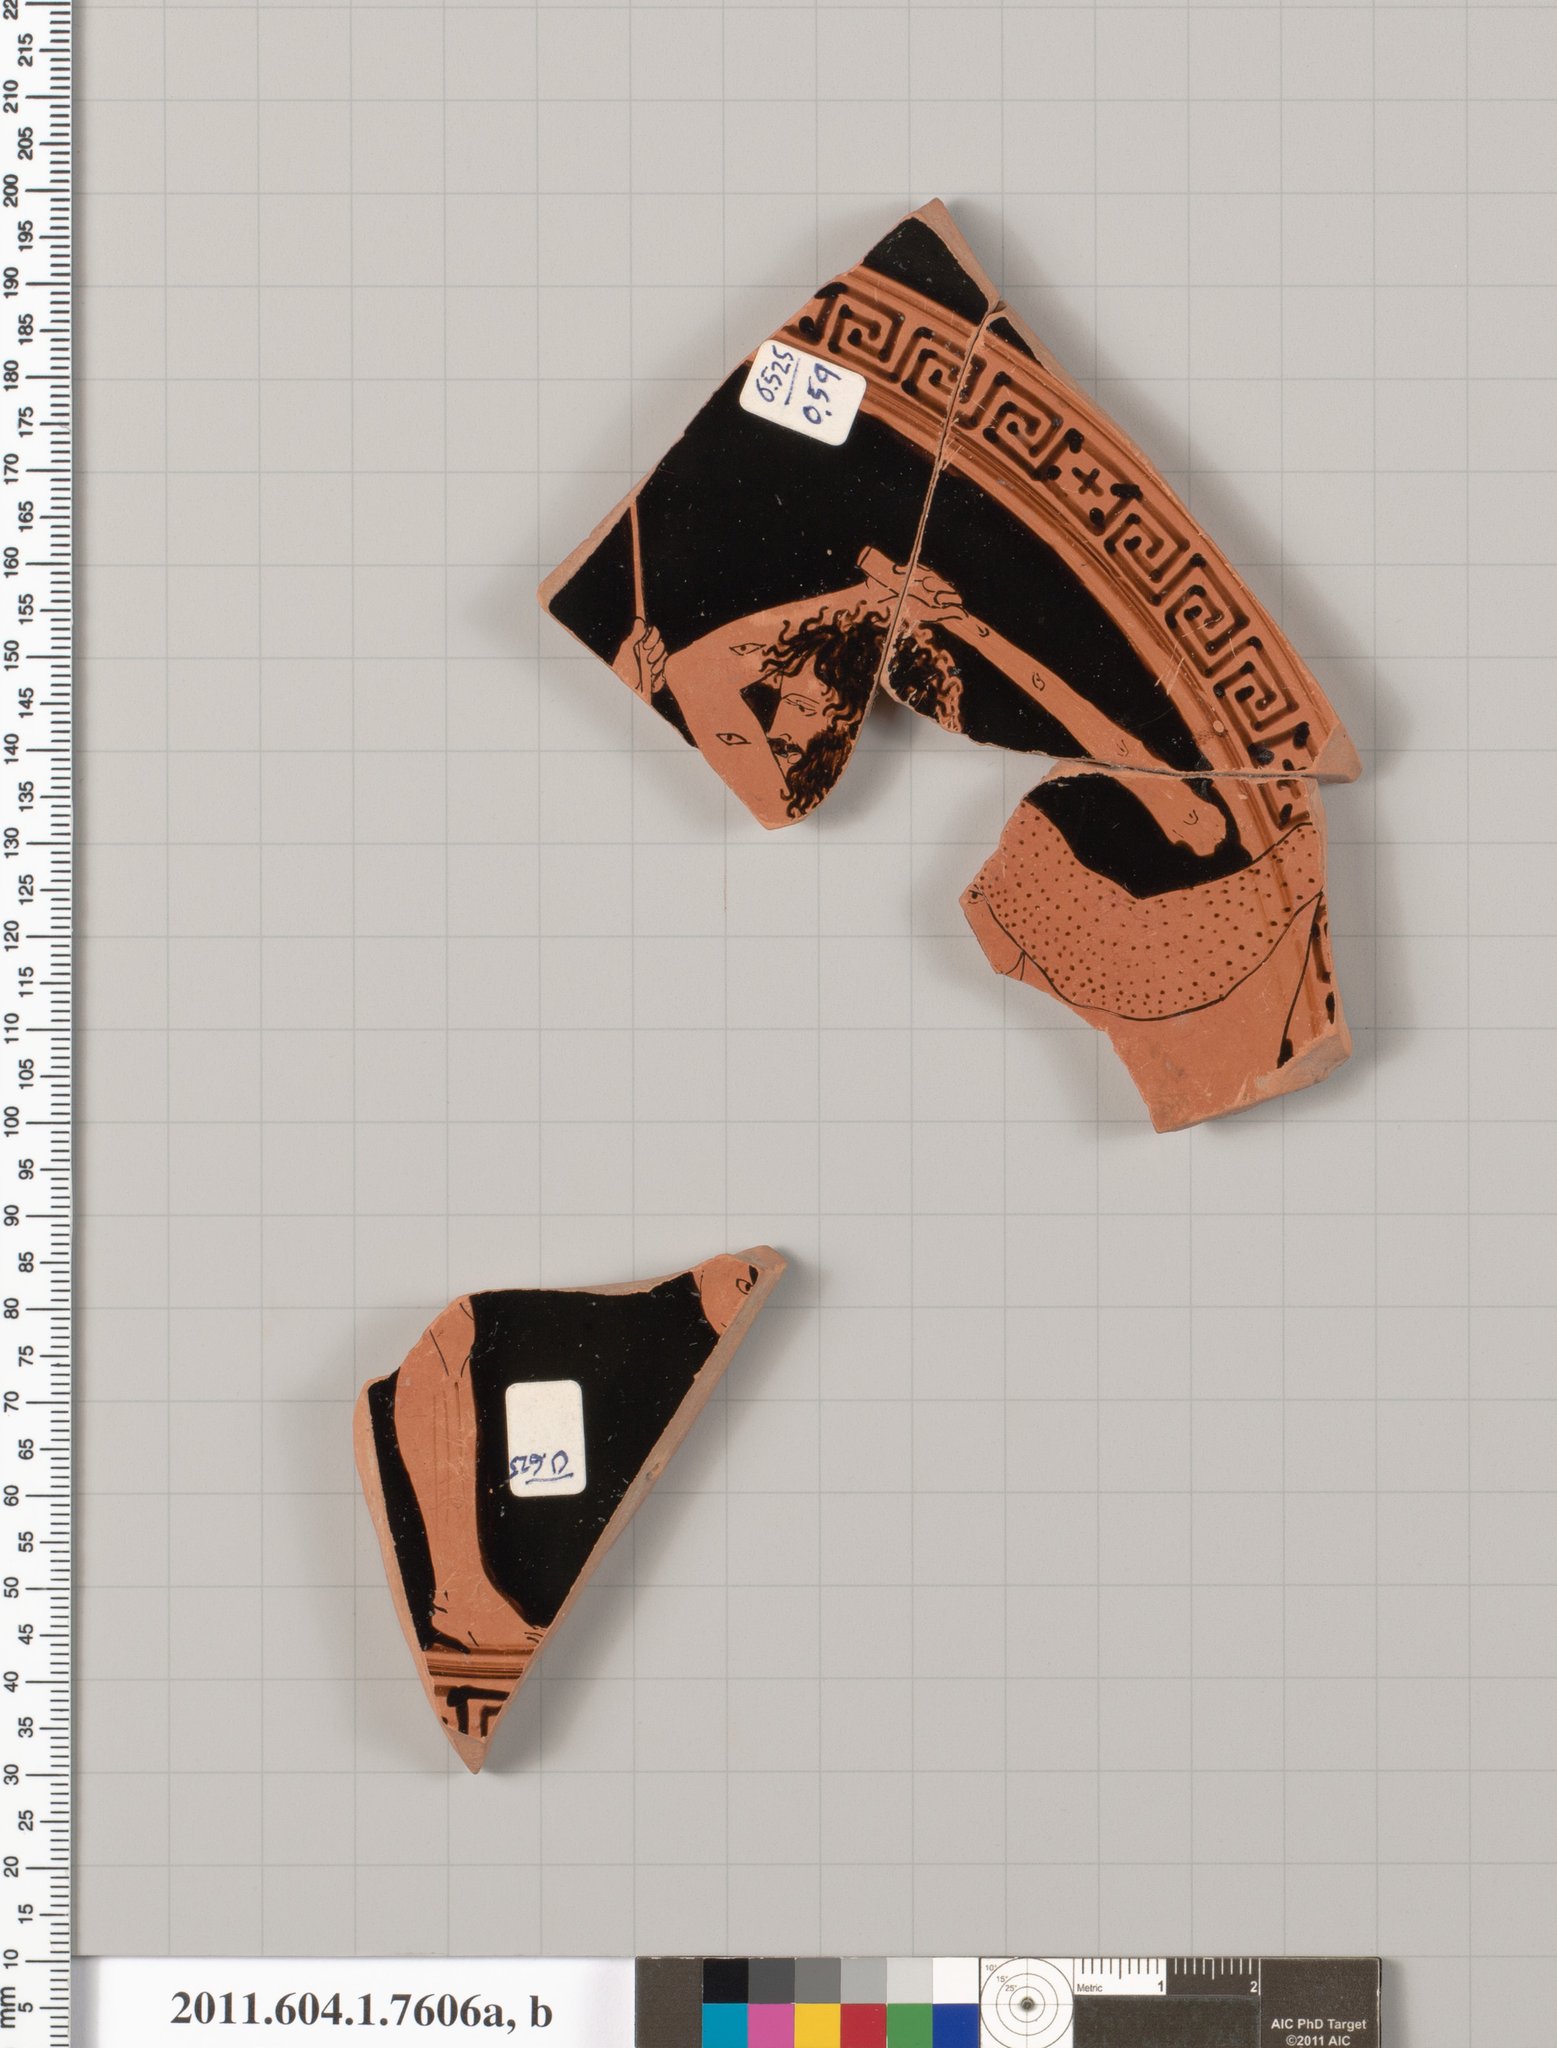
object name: kylix fragment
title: Terracotta fragments of a kylix (drinking cup)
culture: greek, attic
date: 460-450 BCE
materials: terracotta